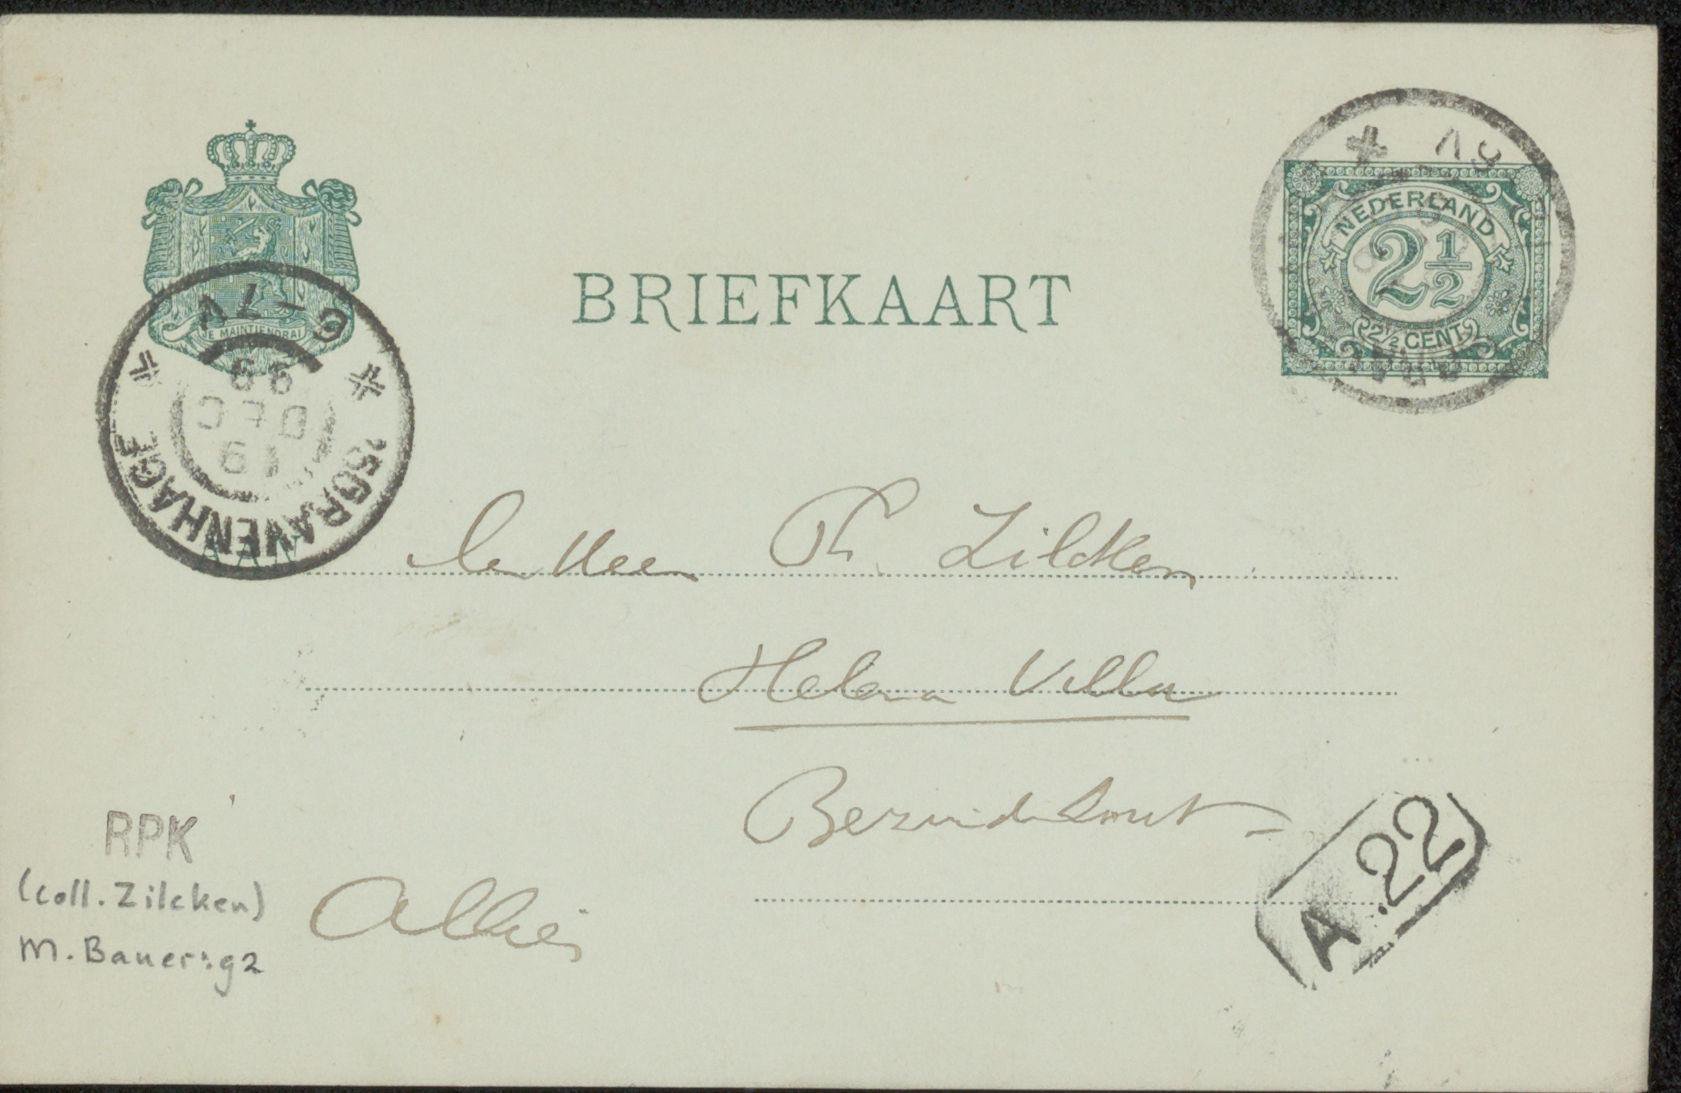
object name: postcard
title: Briefkaart aan Philip Zilcken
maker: marius bauer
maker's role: draughtsman, print maker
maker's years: 1867-1932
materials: cardboard, ink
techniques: pen, writing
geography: the hague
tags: the hague, painter, draughtsman, philip zilcken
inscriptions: collector's mark: ‘RPK’